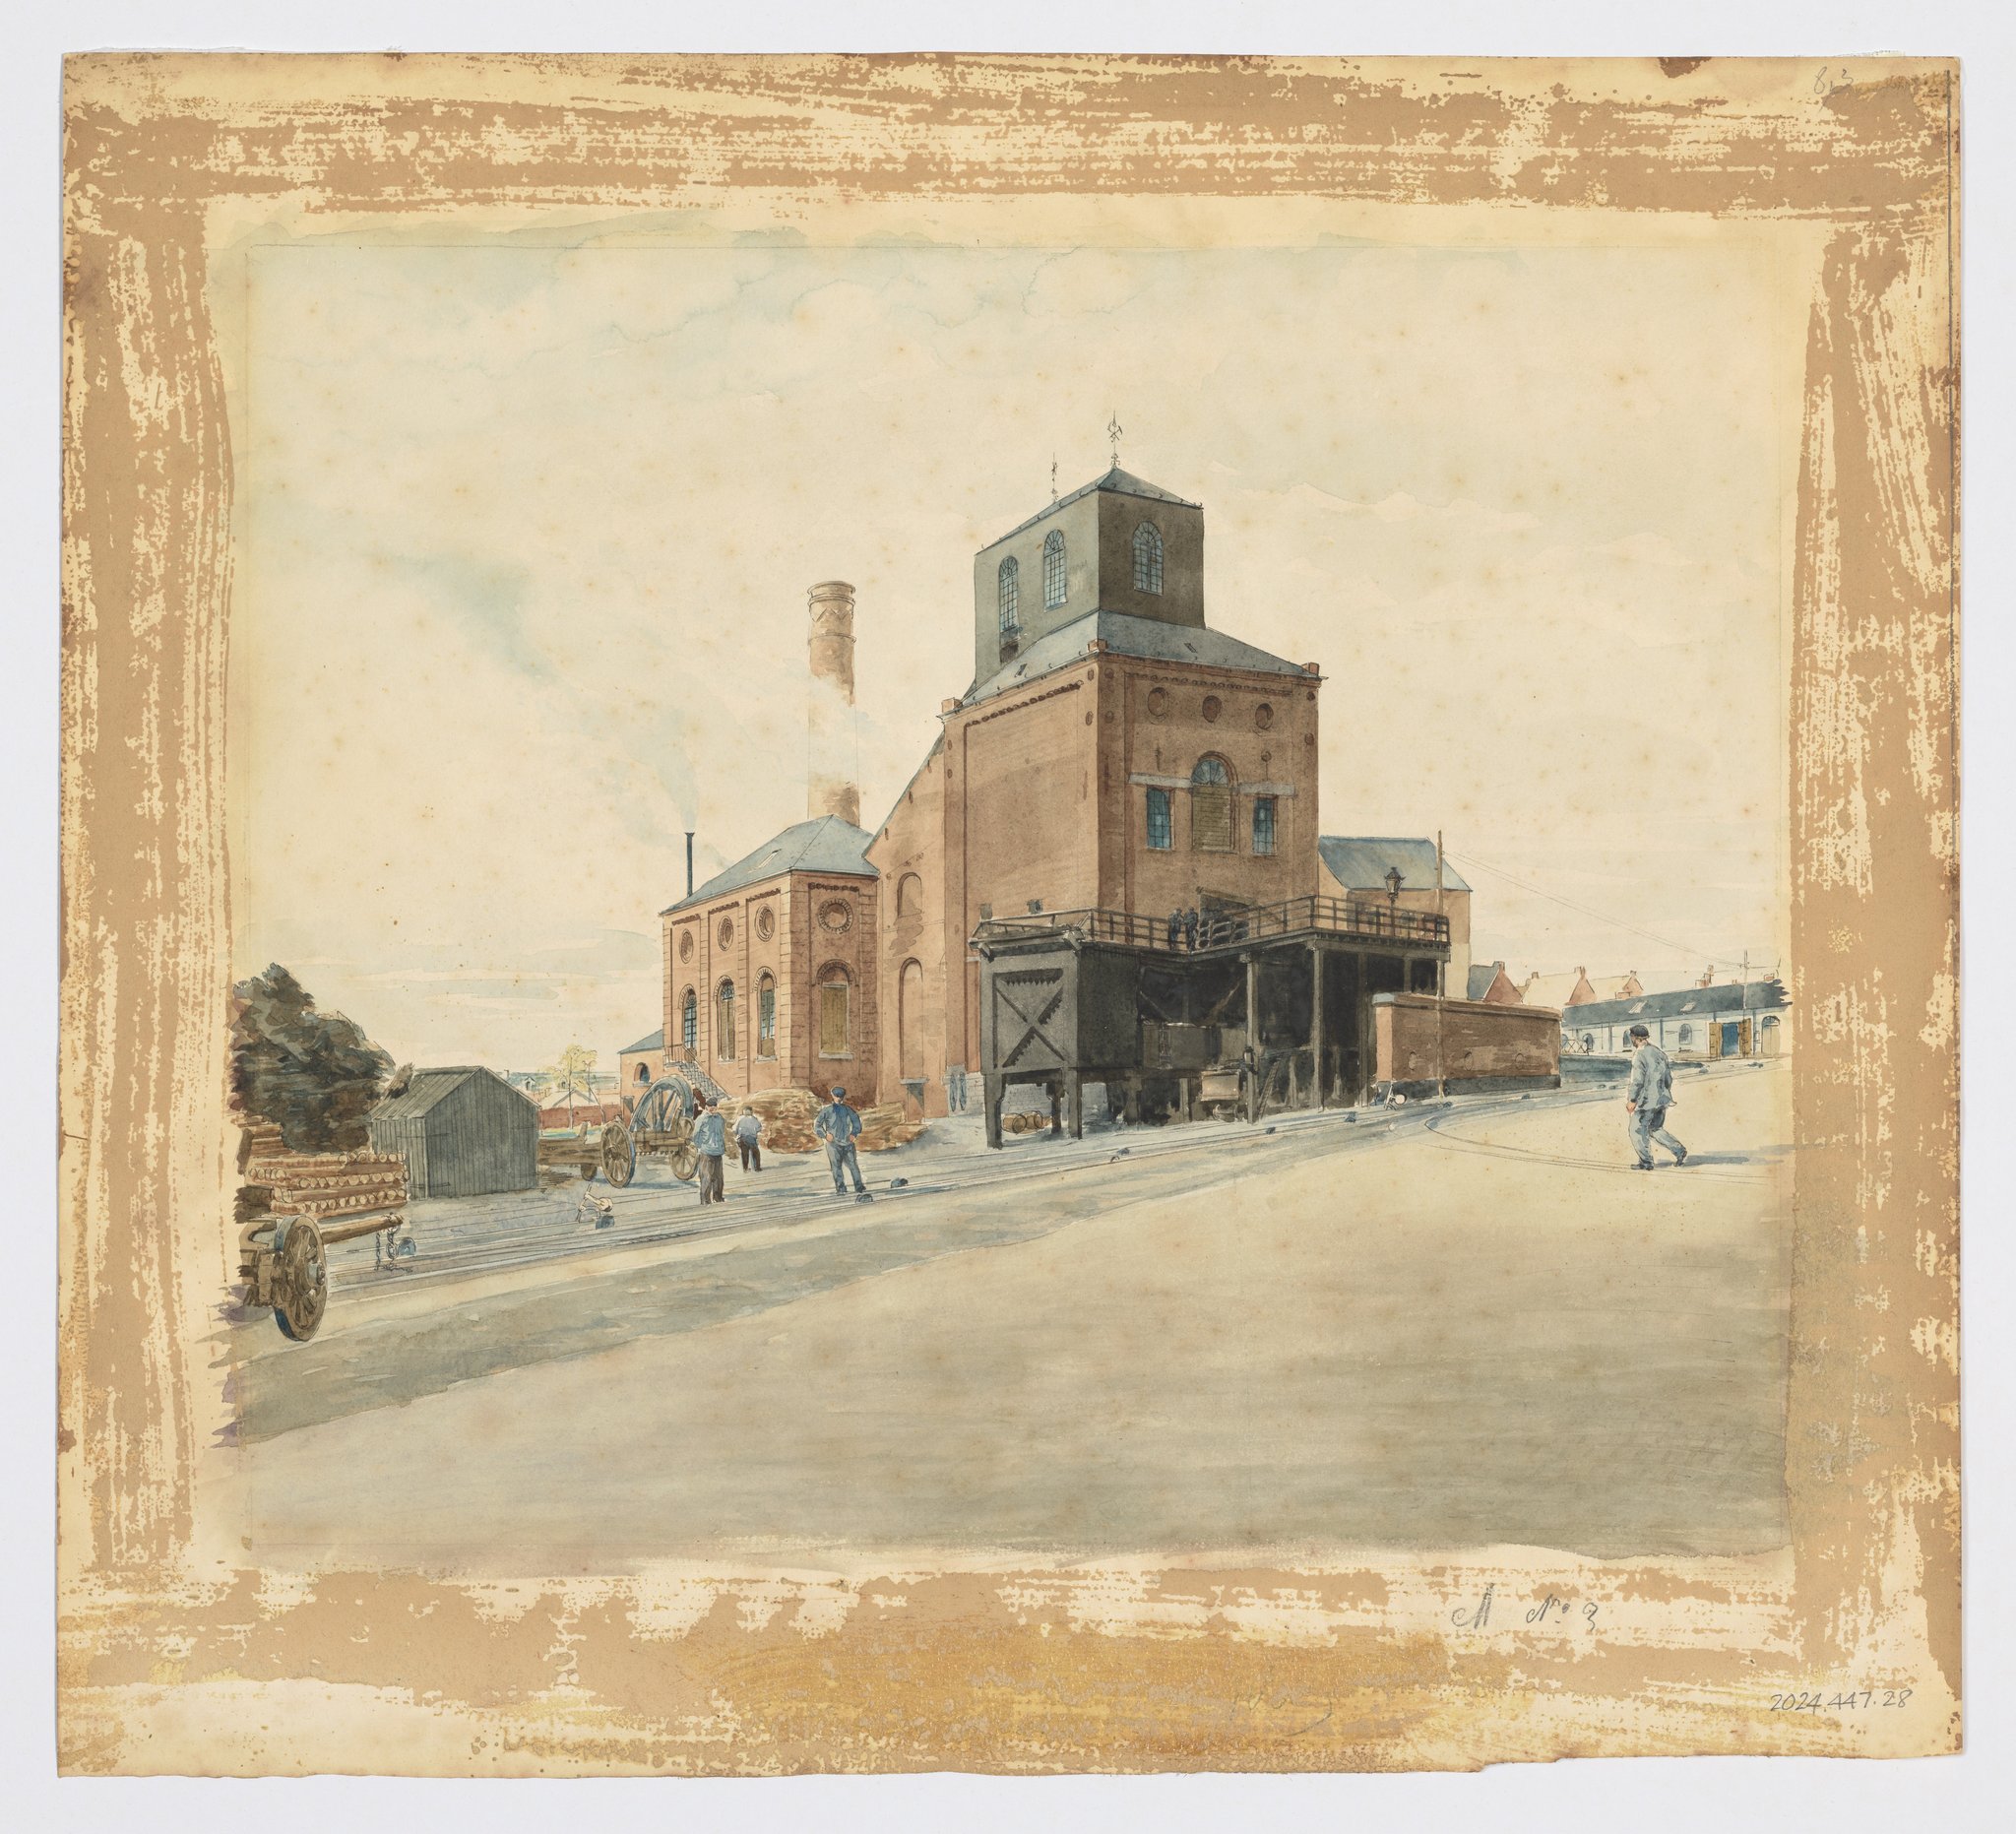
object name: drawing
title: Perspective View from a series of Mines and Factories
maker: th (thomas?) defoiss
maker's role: artist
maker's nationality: french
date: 1905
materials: graphite, ink, watercolor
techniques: pen